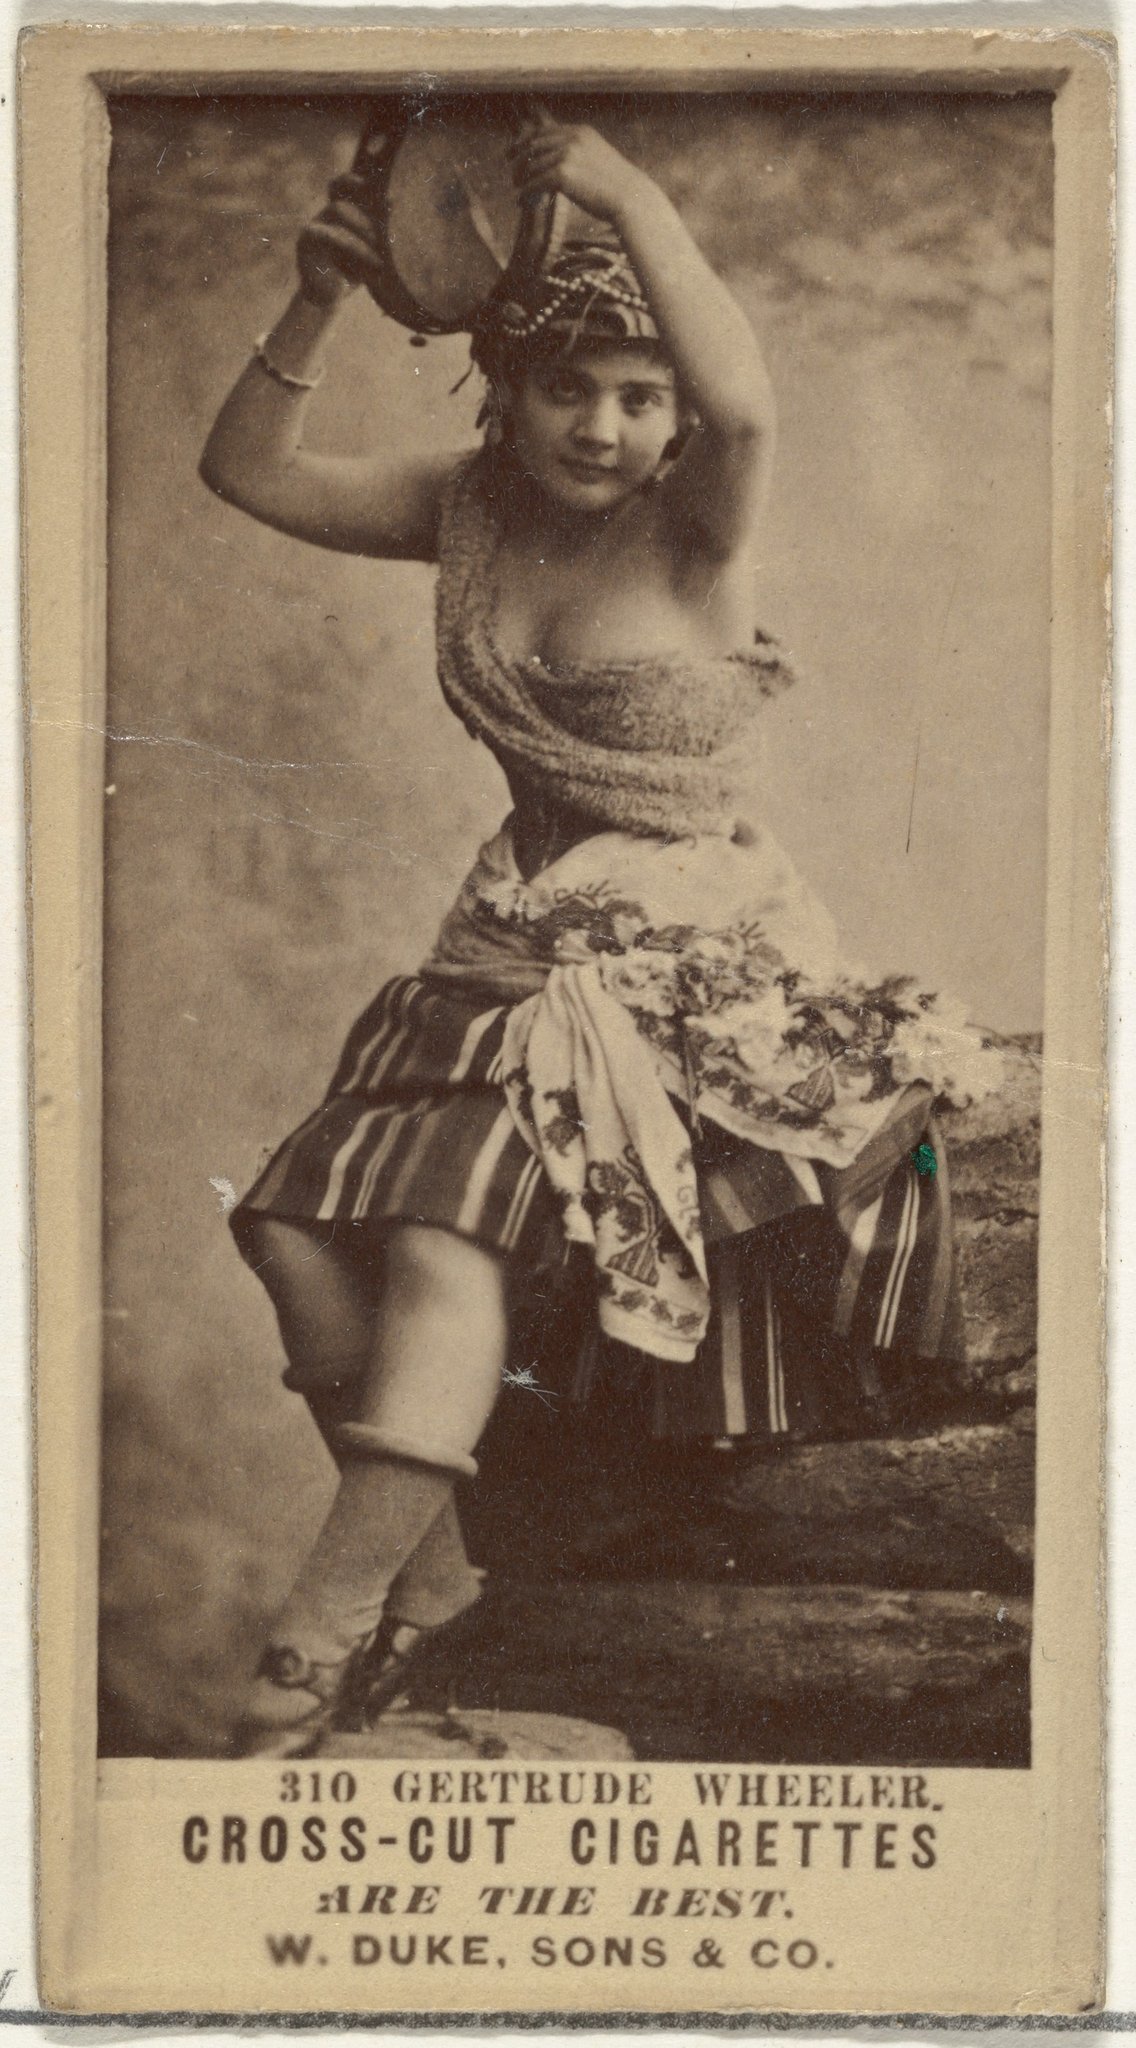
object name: photograph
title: Card Number 310, Gertrude Wheeler, from the Actors and Actresses series (N145-3) issued by Duke Sons & Co. to promote Cross Cut Cigarettes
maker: w. duke, sons & co.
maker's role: publisher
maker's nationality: american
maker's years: 1870-1920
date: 1880-1889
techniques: albumen silver print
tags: portraits,women,actresses